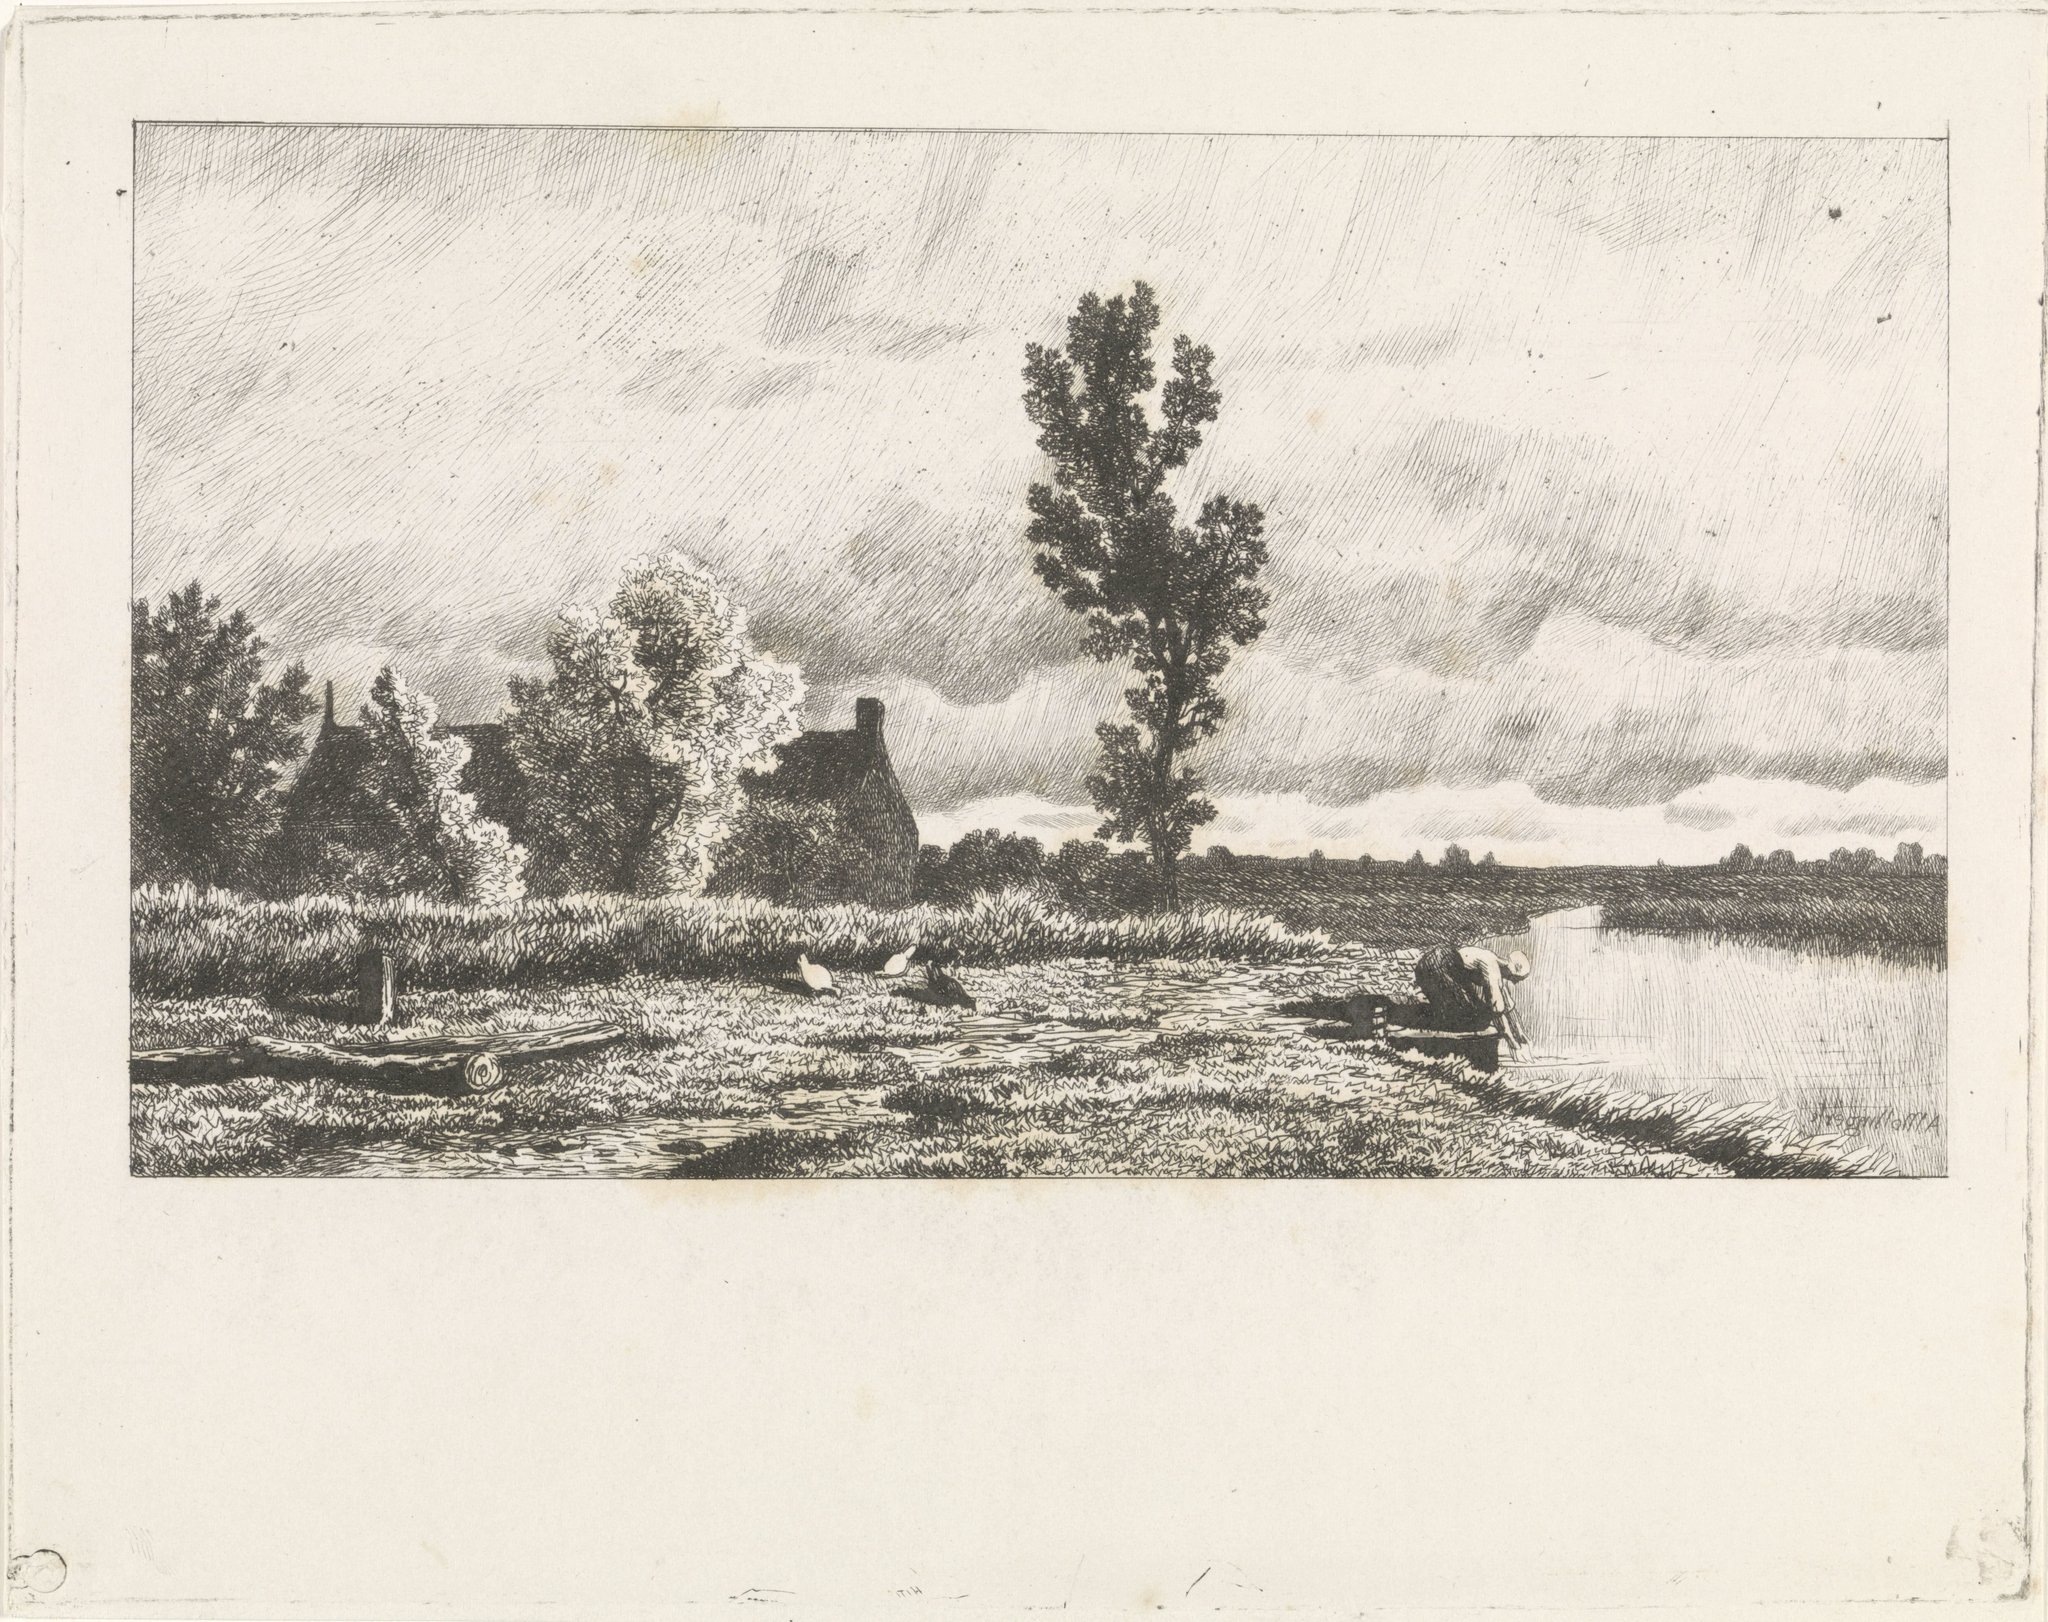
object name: print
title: Landschap met een vrouw die de was doet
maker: alexander mollinger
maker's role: painter, print maker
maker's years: 1836-1867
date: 1860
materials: paper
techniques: etching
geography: netherlands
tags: clouds, laundering, farm or solitary house in landscape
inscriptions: collector's mark: Lugt 2228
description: Op een steiger aan het water doet een vrouw de was. In het weiland kippen, links een woning.